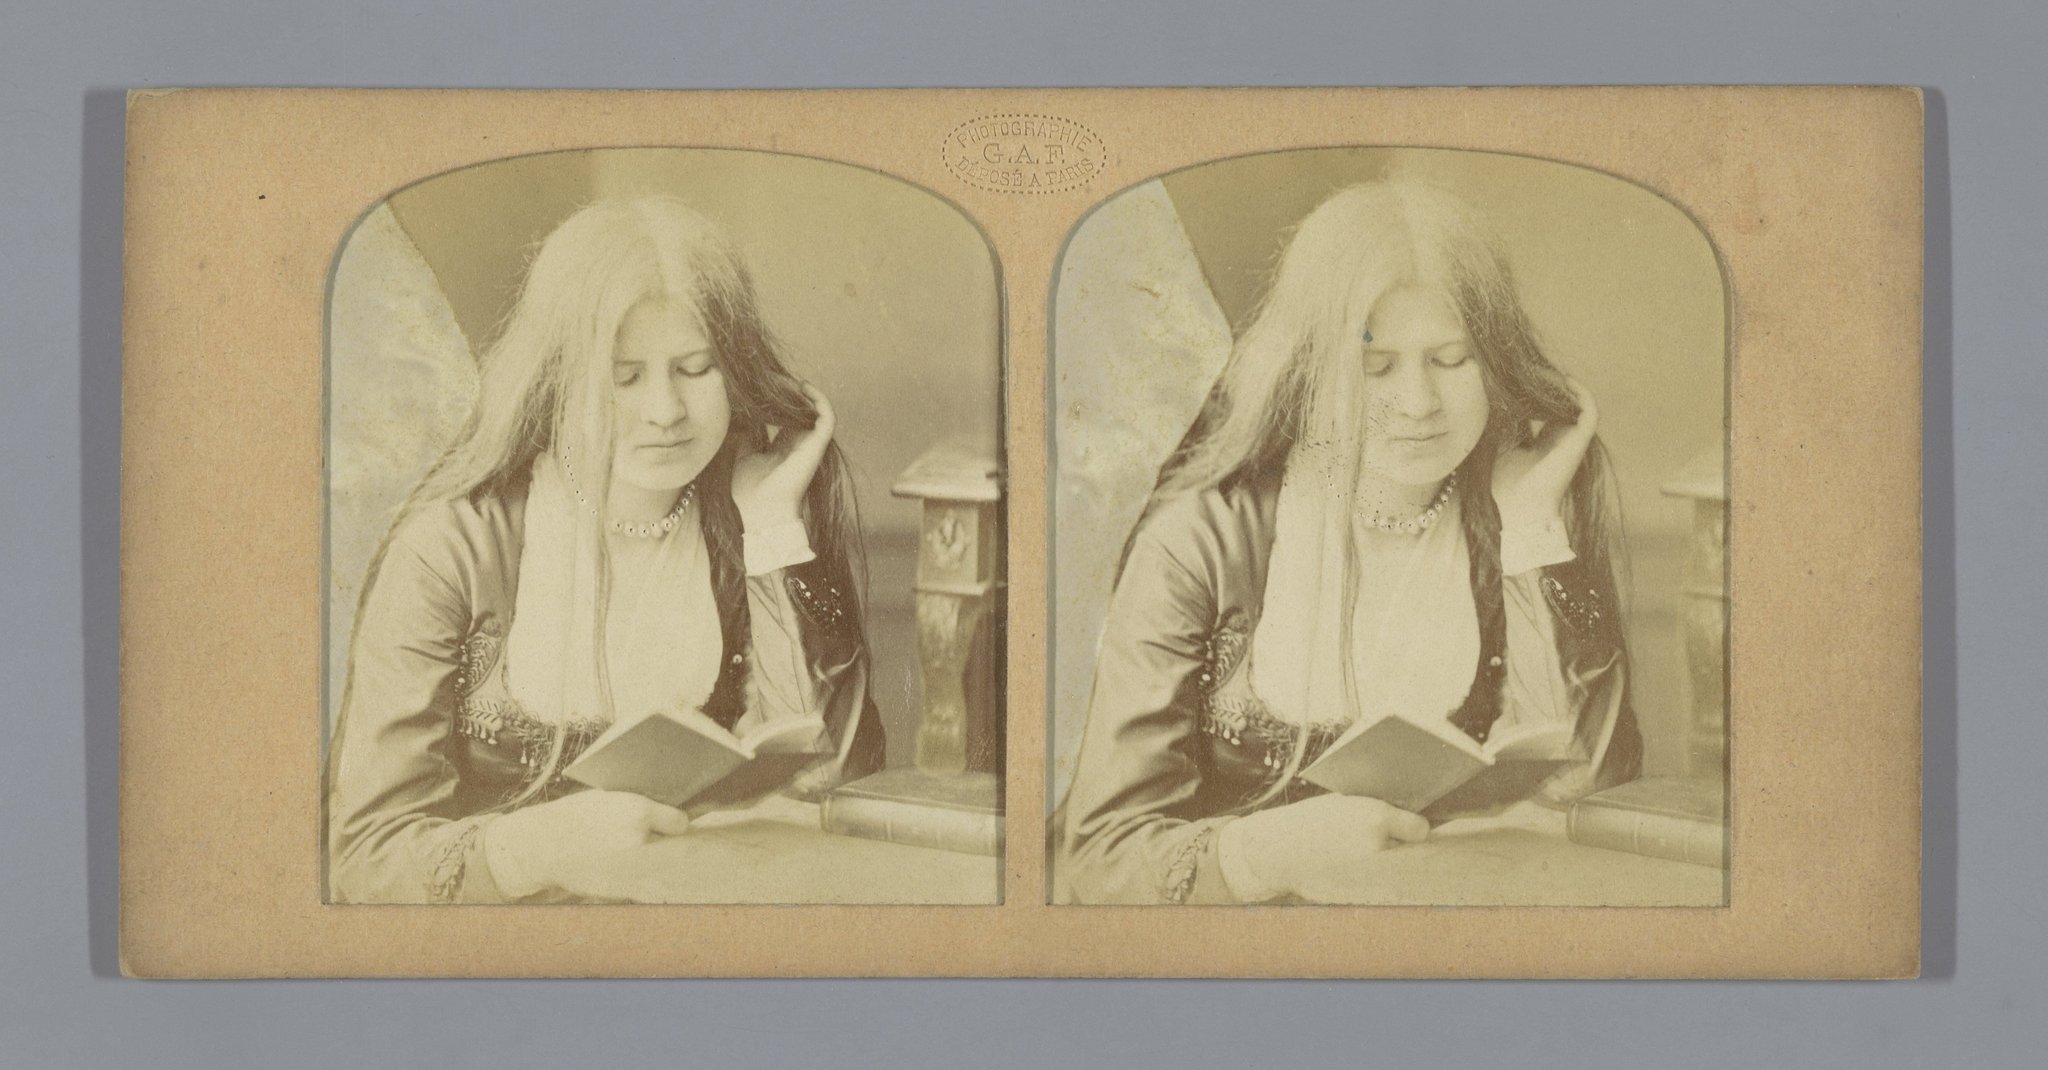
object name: tissue stereograph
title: Jonge vrouw leest boek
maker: florent grau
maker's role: manufacturer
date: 1855-1868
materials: cardboard, paper, photographic support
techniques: albumen print, hand coloring, perforating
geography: paris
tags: reading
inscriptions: inscription: ‘DÉPOSÉ A PARIS’